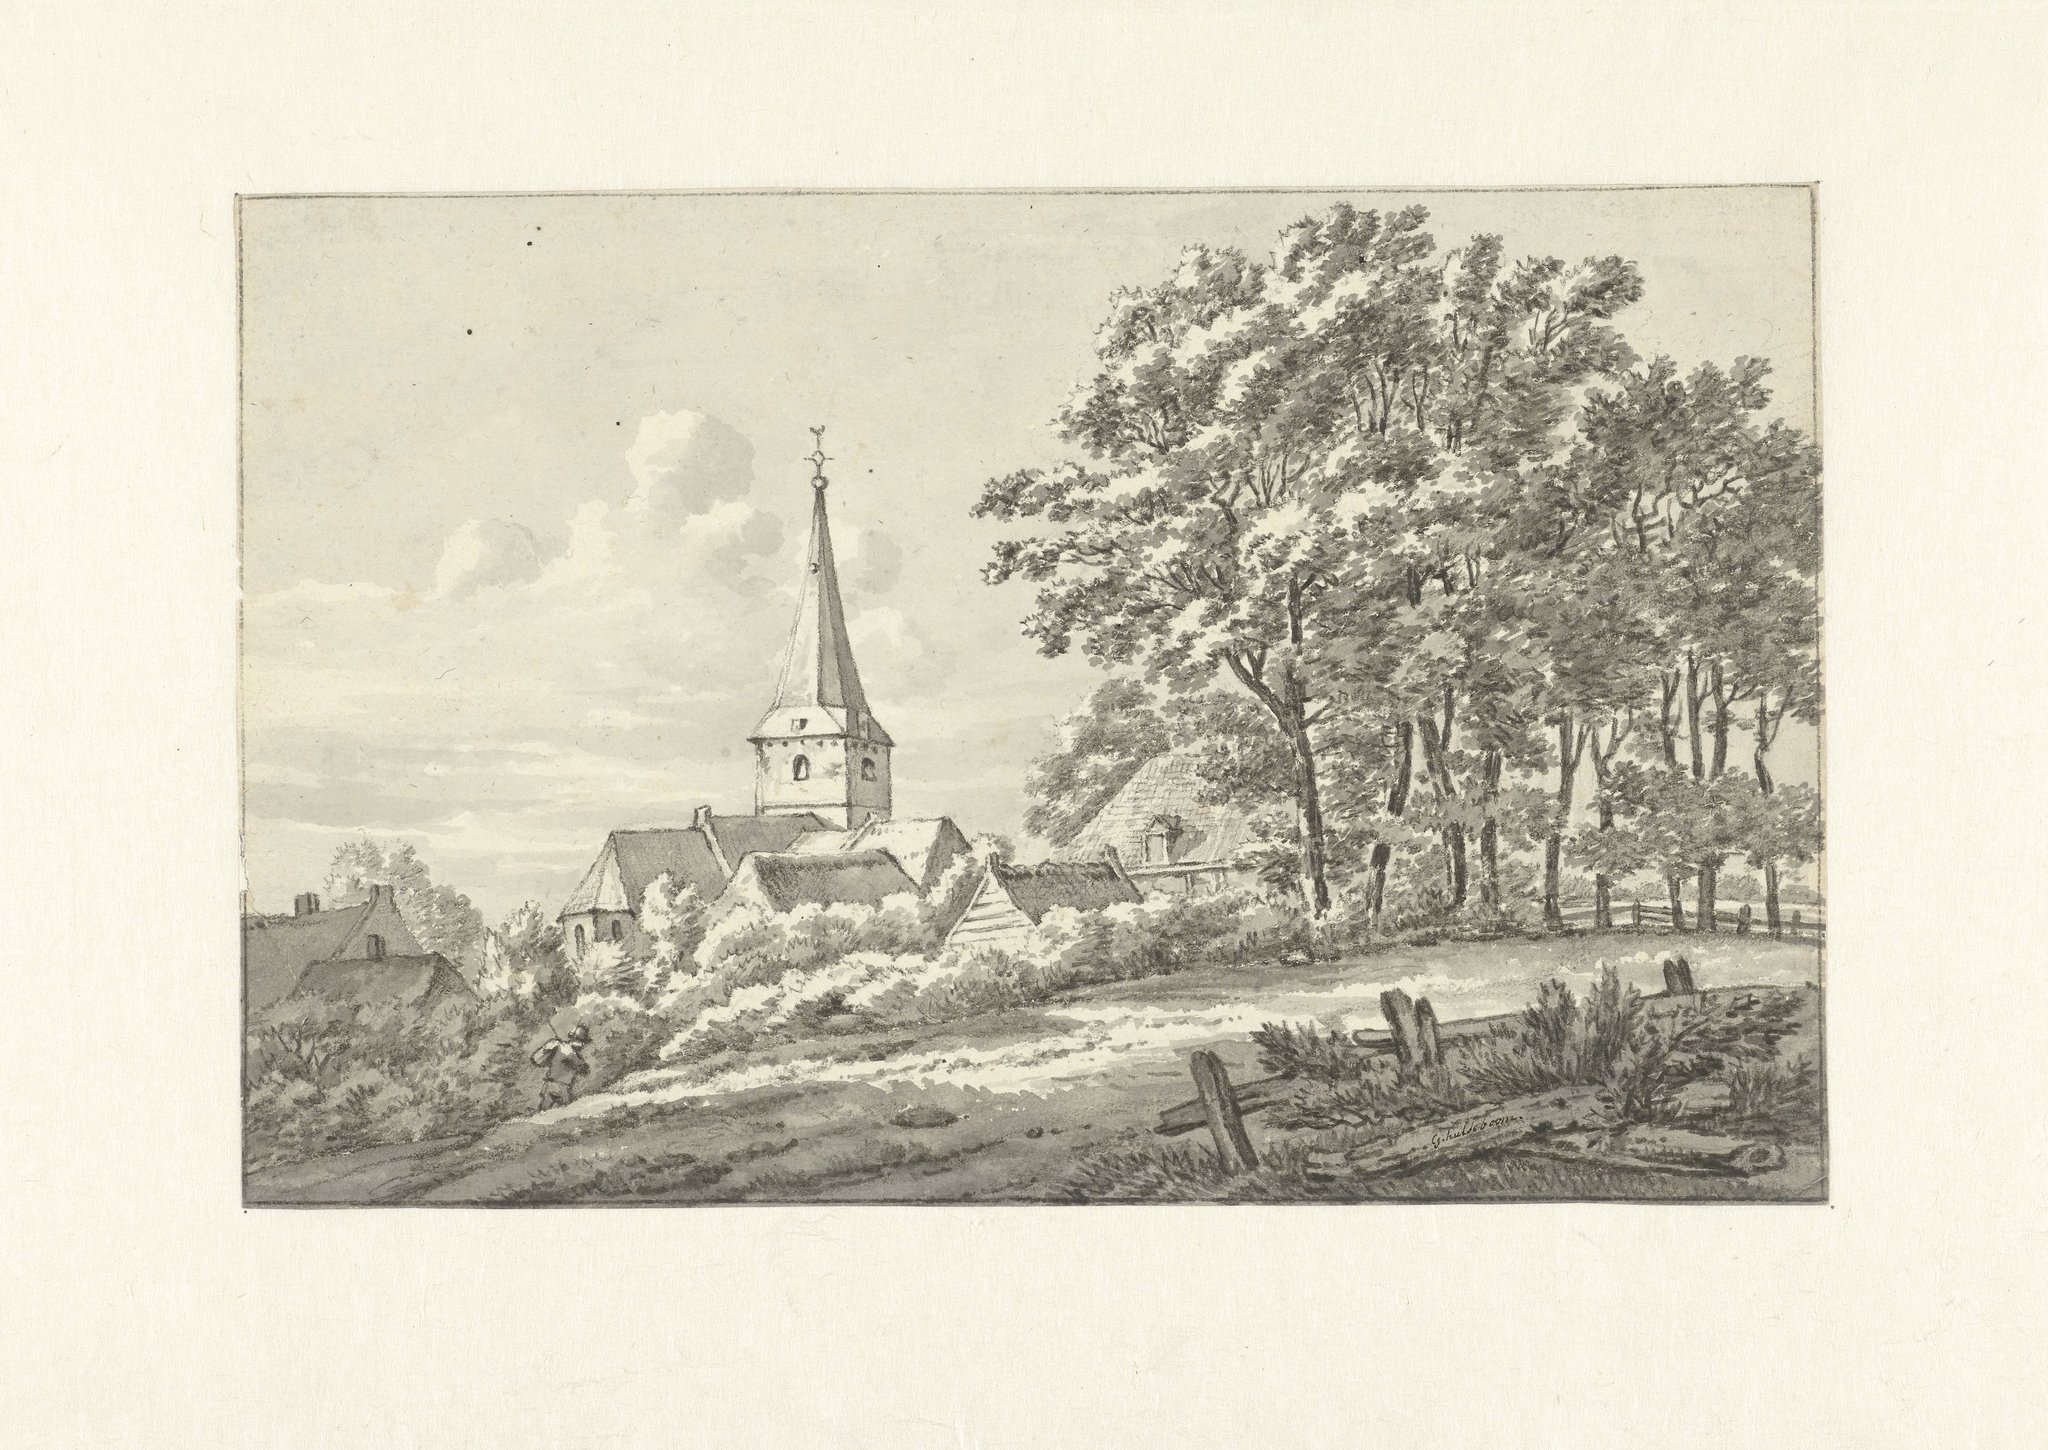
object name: drawing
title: Vaassen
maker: gerrit hulseboom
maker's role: draughtsman, print maker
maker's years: 1784-1863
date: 1794-1863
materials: chalk, paper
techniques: brush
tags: prospect of village, silhouette of village